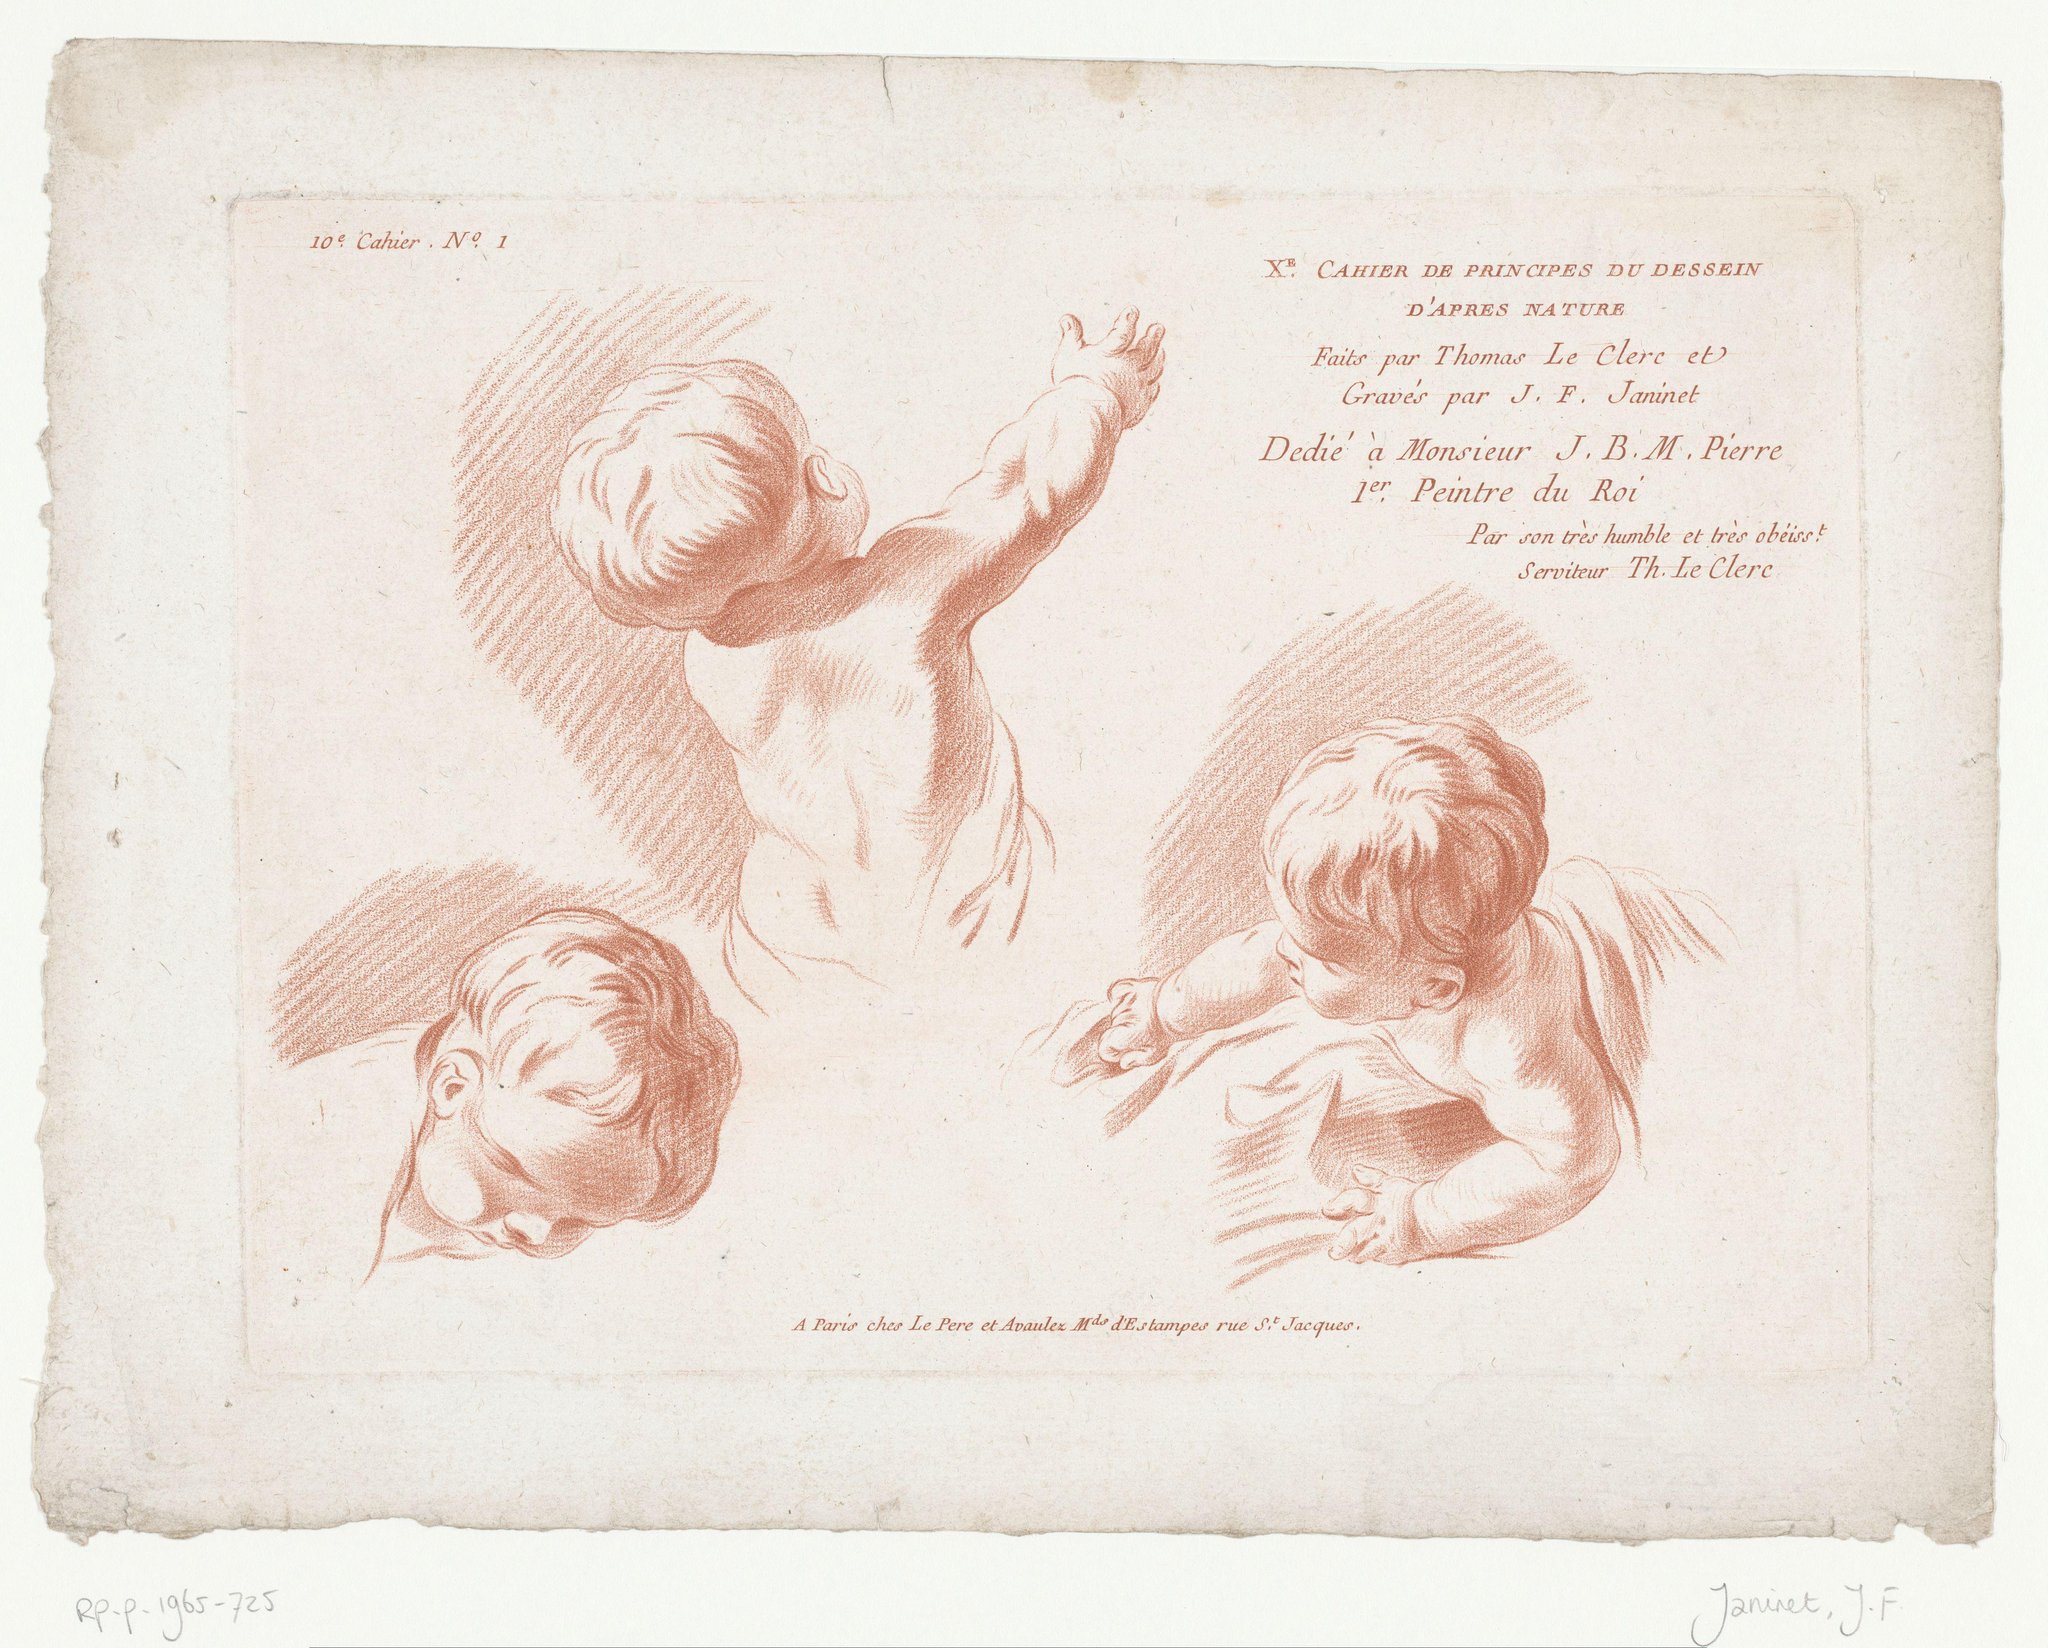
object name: titelprent, frontispice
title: X.e Cahier de principes du dessin d'apres nature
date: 1773-1777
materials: paper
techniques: printmaking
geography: paris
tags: child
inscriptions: collector's mark: Lugt 2228, watermark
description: Deze prent maakt deel uit van een album dat uit minstens elf delen bestaat. Dit is het eerste blad van het tiende album. Waarschijnlijk dienden deze albums als voorbeeld voor tekenaars, schilders en graveurs.